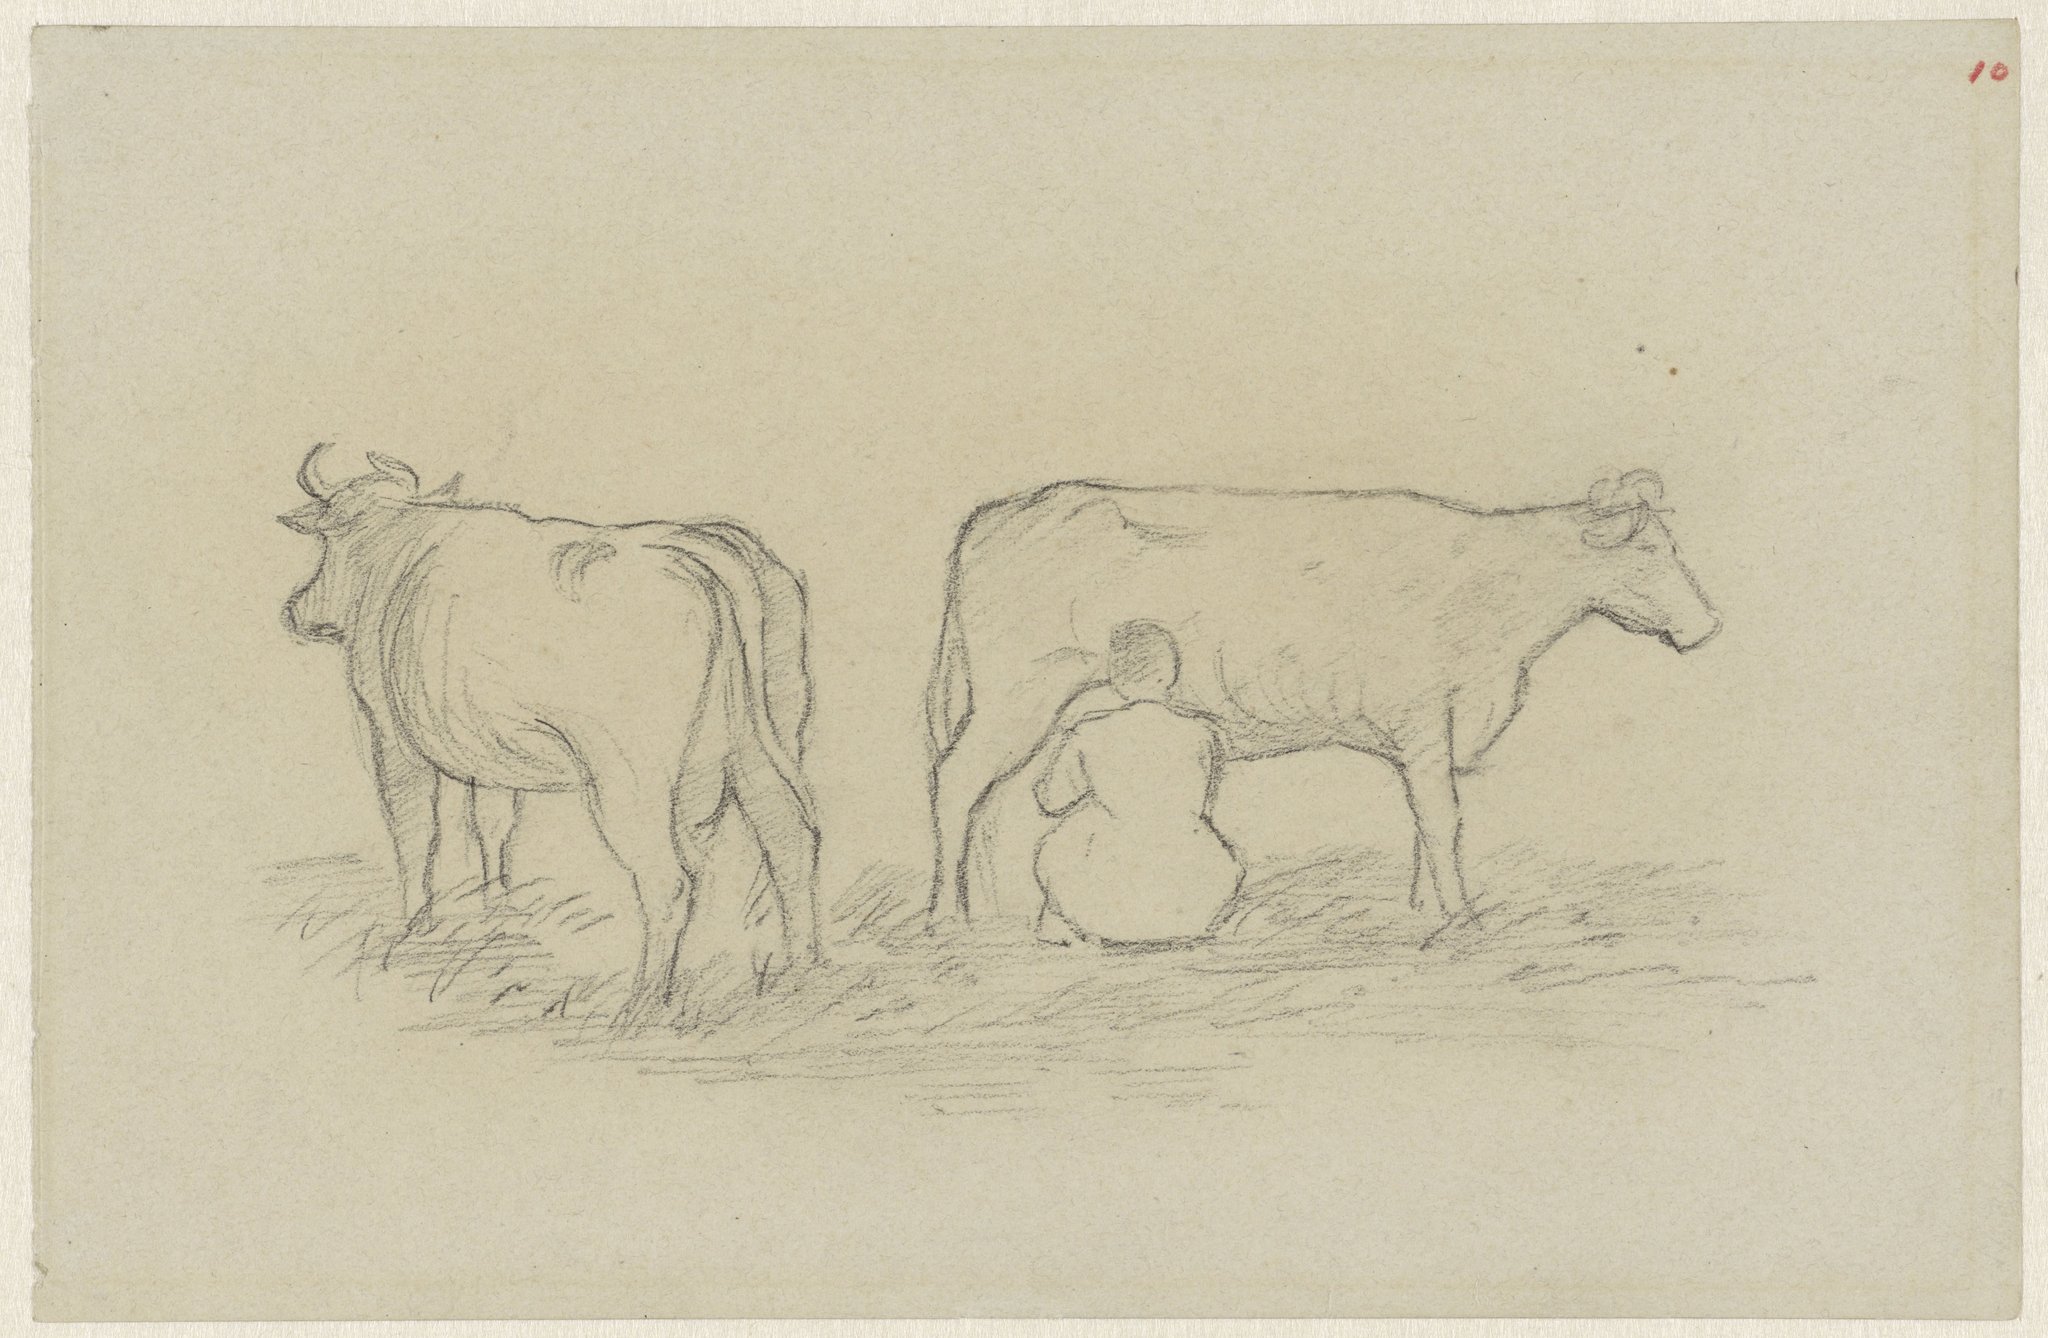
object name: drawing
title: Twee koeien en een melkend meisje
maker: jozef israëls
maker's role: draughtsman, painter, print maker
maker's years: 1824-1911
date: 1834-1911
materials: chalk, paper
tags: cow, milking